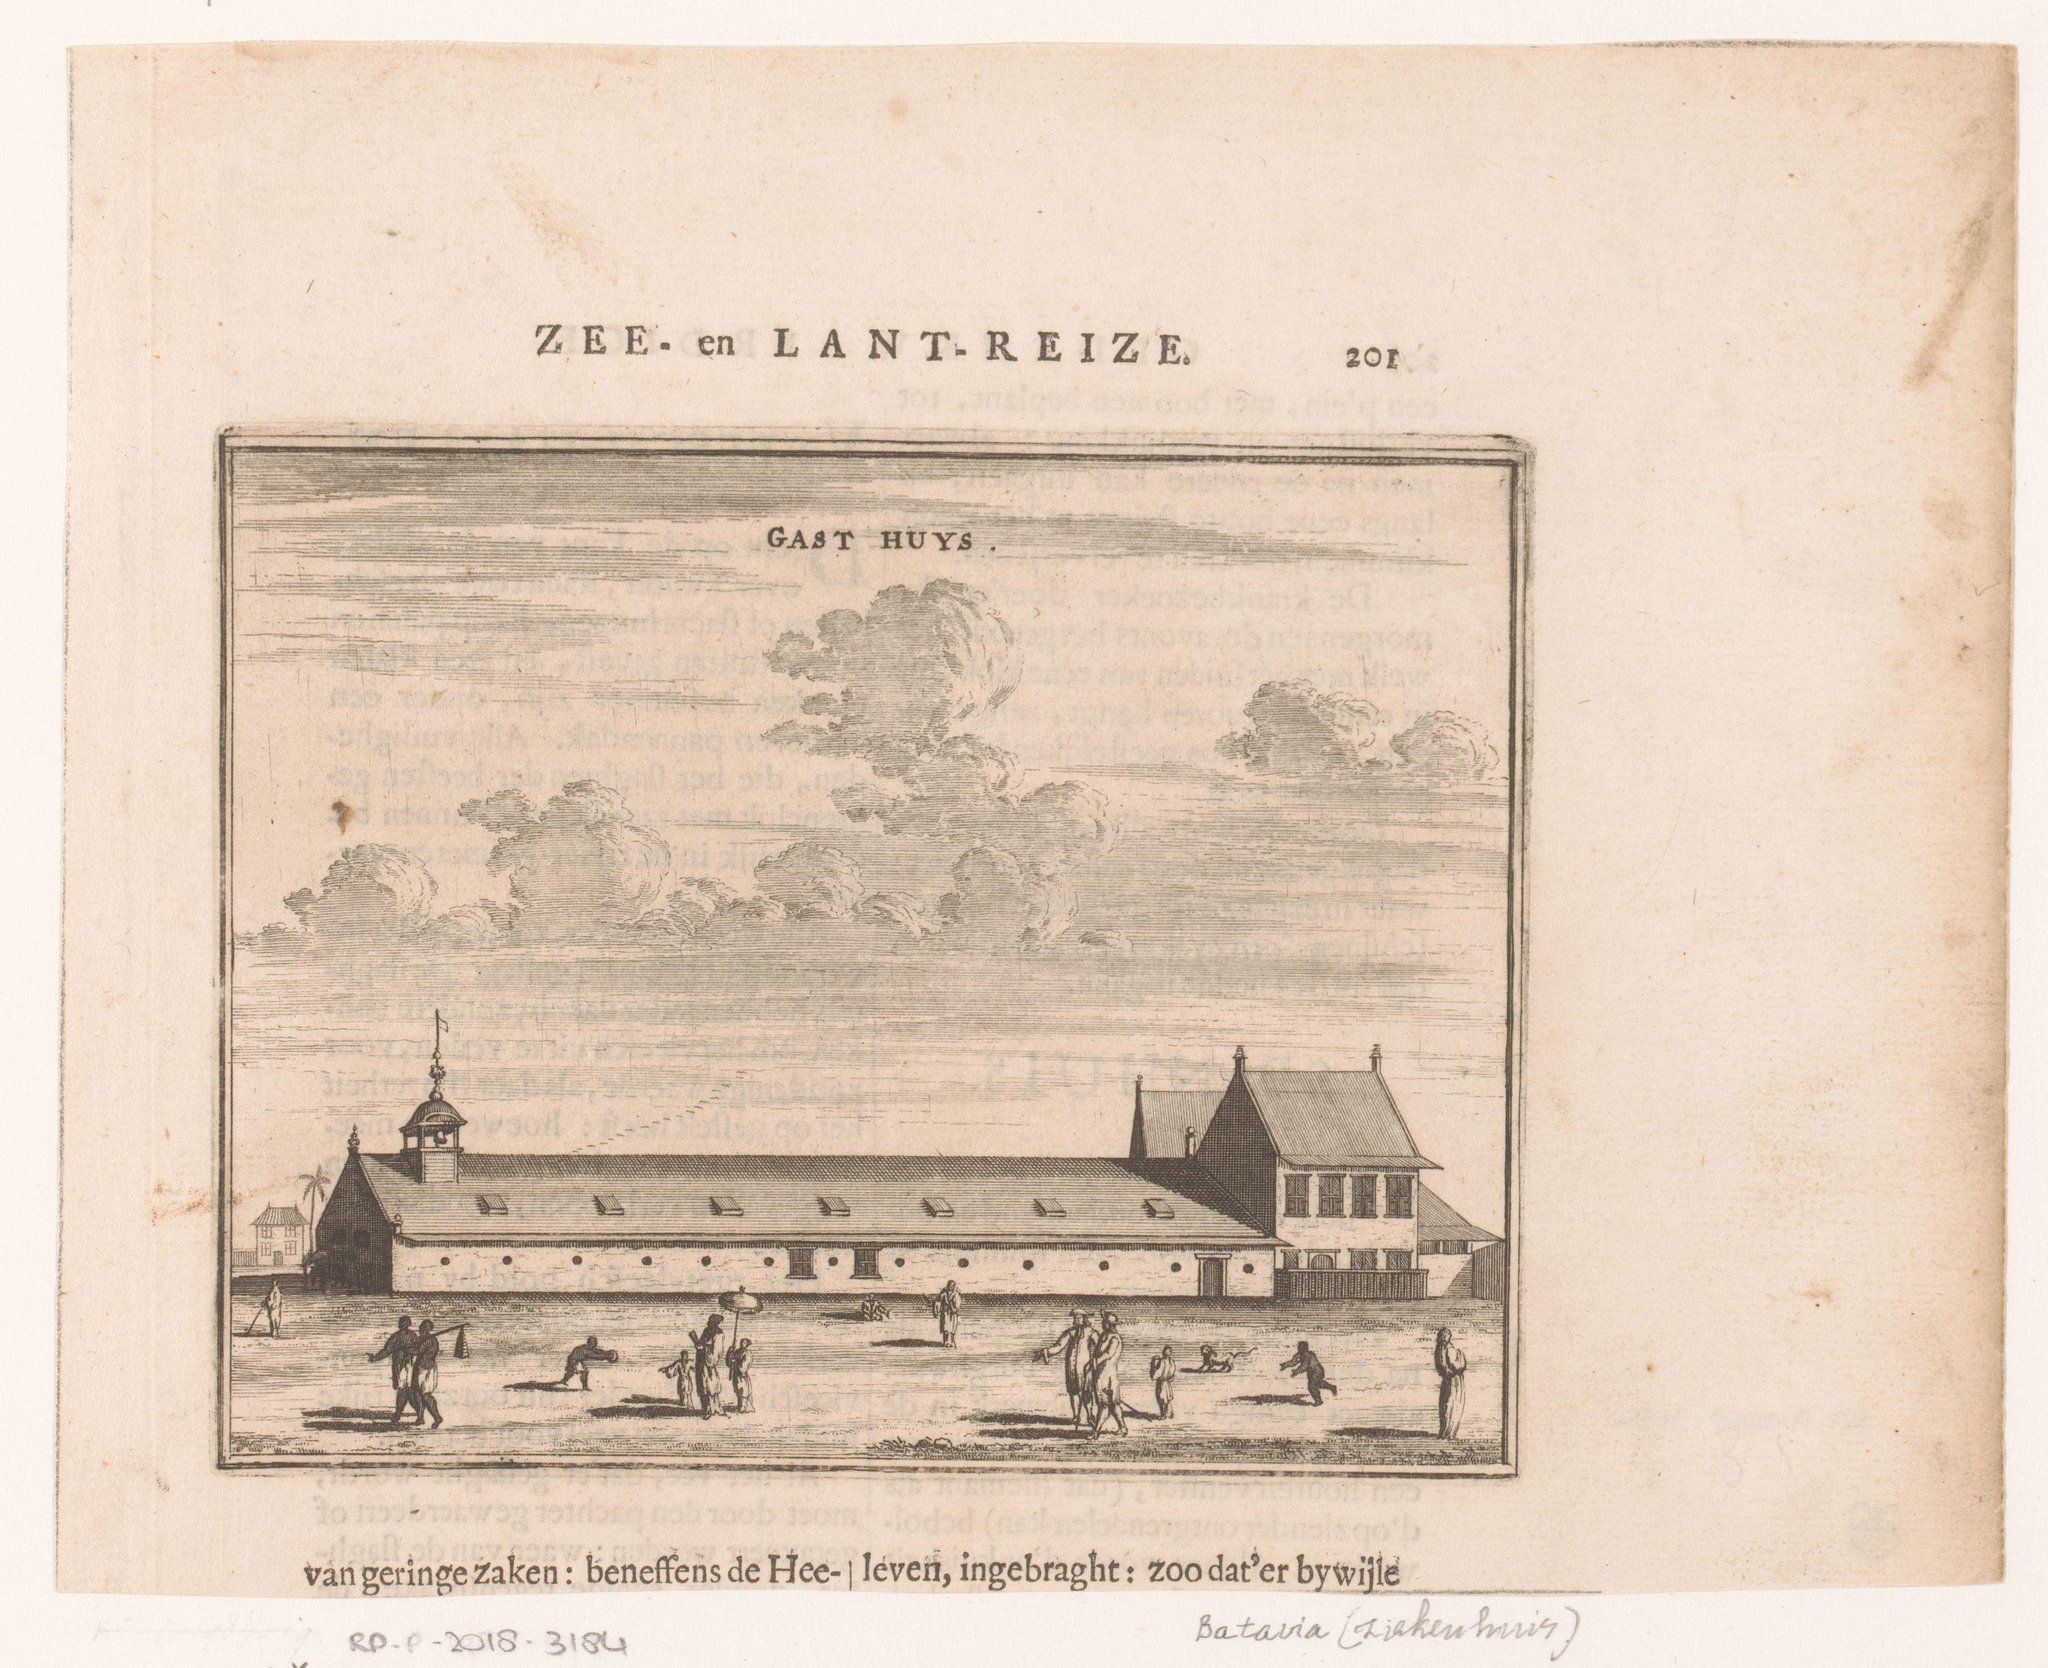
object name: book illustration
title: Gezicht op het ziekenhuis van Batavia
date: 1682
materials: paper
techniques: engraving, letterpress printing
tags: hospital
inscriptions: collector's mark: Lugt 2228, collector's mark: Lugt 2760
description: Prent uit: Nieuhof, Joan. Joan Nieuhofs zee en lant-reize, door verscheide Gewesten van Oostindien (...). Amsterdam: Jacob van Meurs, 1682, p. 201.